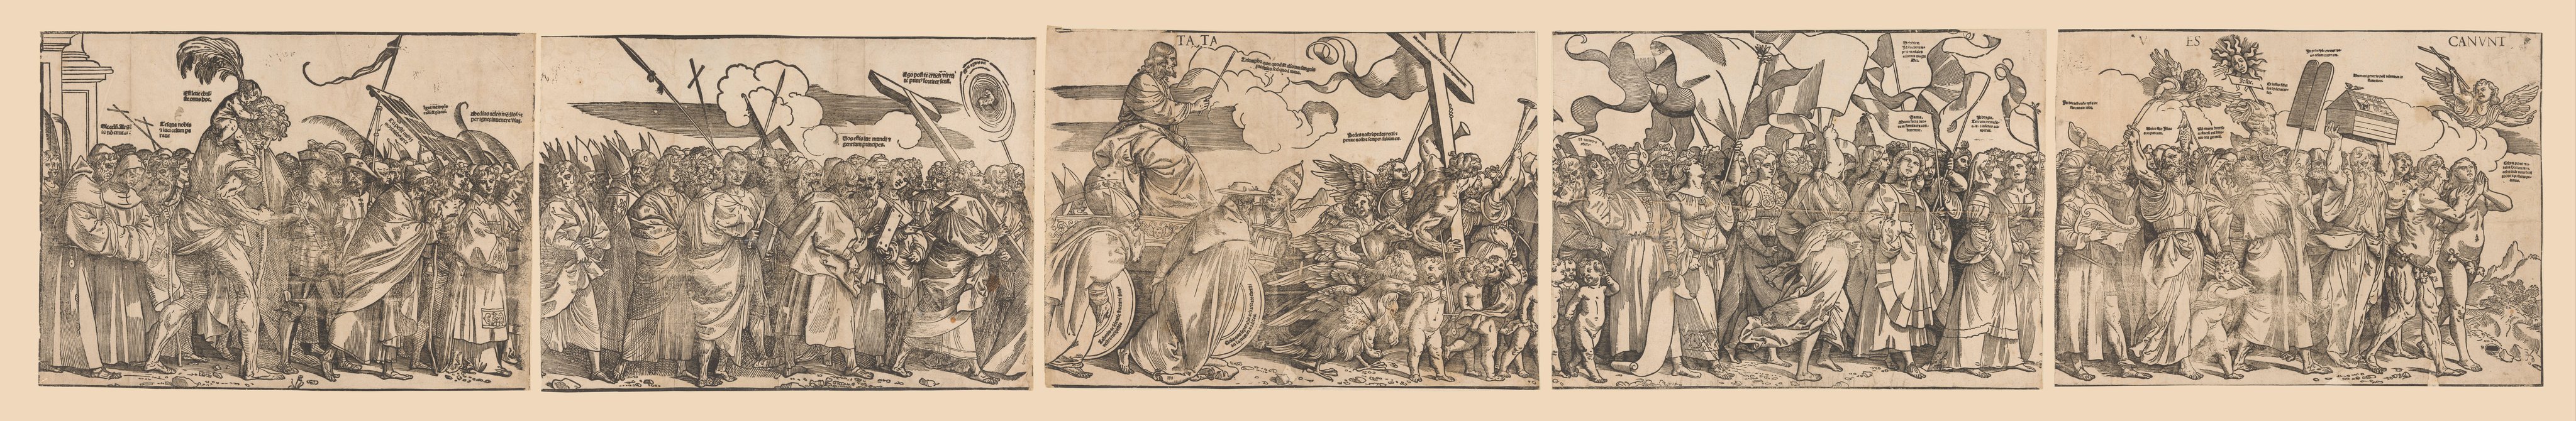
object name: print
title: Triomf van Christus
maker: Anonymous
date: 1517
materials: paper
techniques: woodcut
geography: italy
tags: the martyr and deacon laurence of rome; possible attributes: book, censer, cross, dalmatic, gridiron, palm, purse (or cup with golden coins), male persons from the old testament (not in biblical context), sibyls, banner, standard (as symbol of the state, etc.), adam and eve (not in biblical context), female persons from the old testament (not in biblical context), organization, functionaries and dignitaries in roman catholic church; clergy in general, st. christopher, with the infant christ on his shoulders, wading through the water and carrying his staff (palm-tree); sometimes a hermit stands on the further bank beside a chapel, a lantern in his hand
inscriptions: collector's mark: Lugt 240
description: Fries bestaande uit vijf houtsnedes die samen de Triomf van Christus vormen. Ten opzichte van het door Rosand en Muraro beschreven exemplaar (cat.nr. 2) mist grotendeels het doorlopende Latijnse opschrift langs de bovenzijde van de vijf prenten, alsook sommige van de andere Latijnse opschriften waaronder het uitgeversadres van Gregorio de' Gregoriis. Dit object is omwille van een betere presentatie virtueel samengevoegd maar bestaat fysiek uit losse onderdelen.